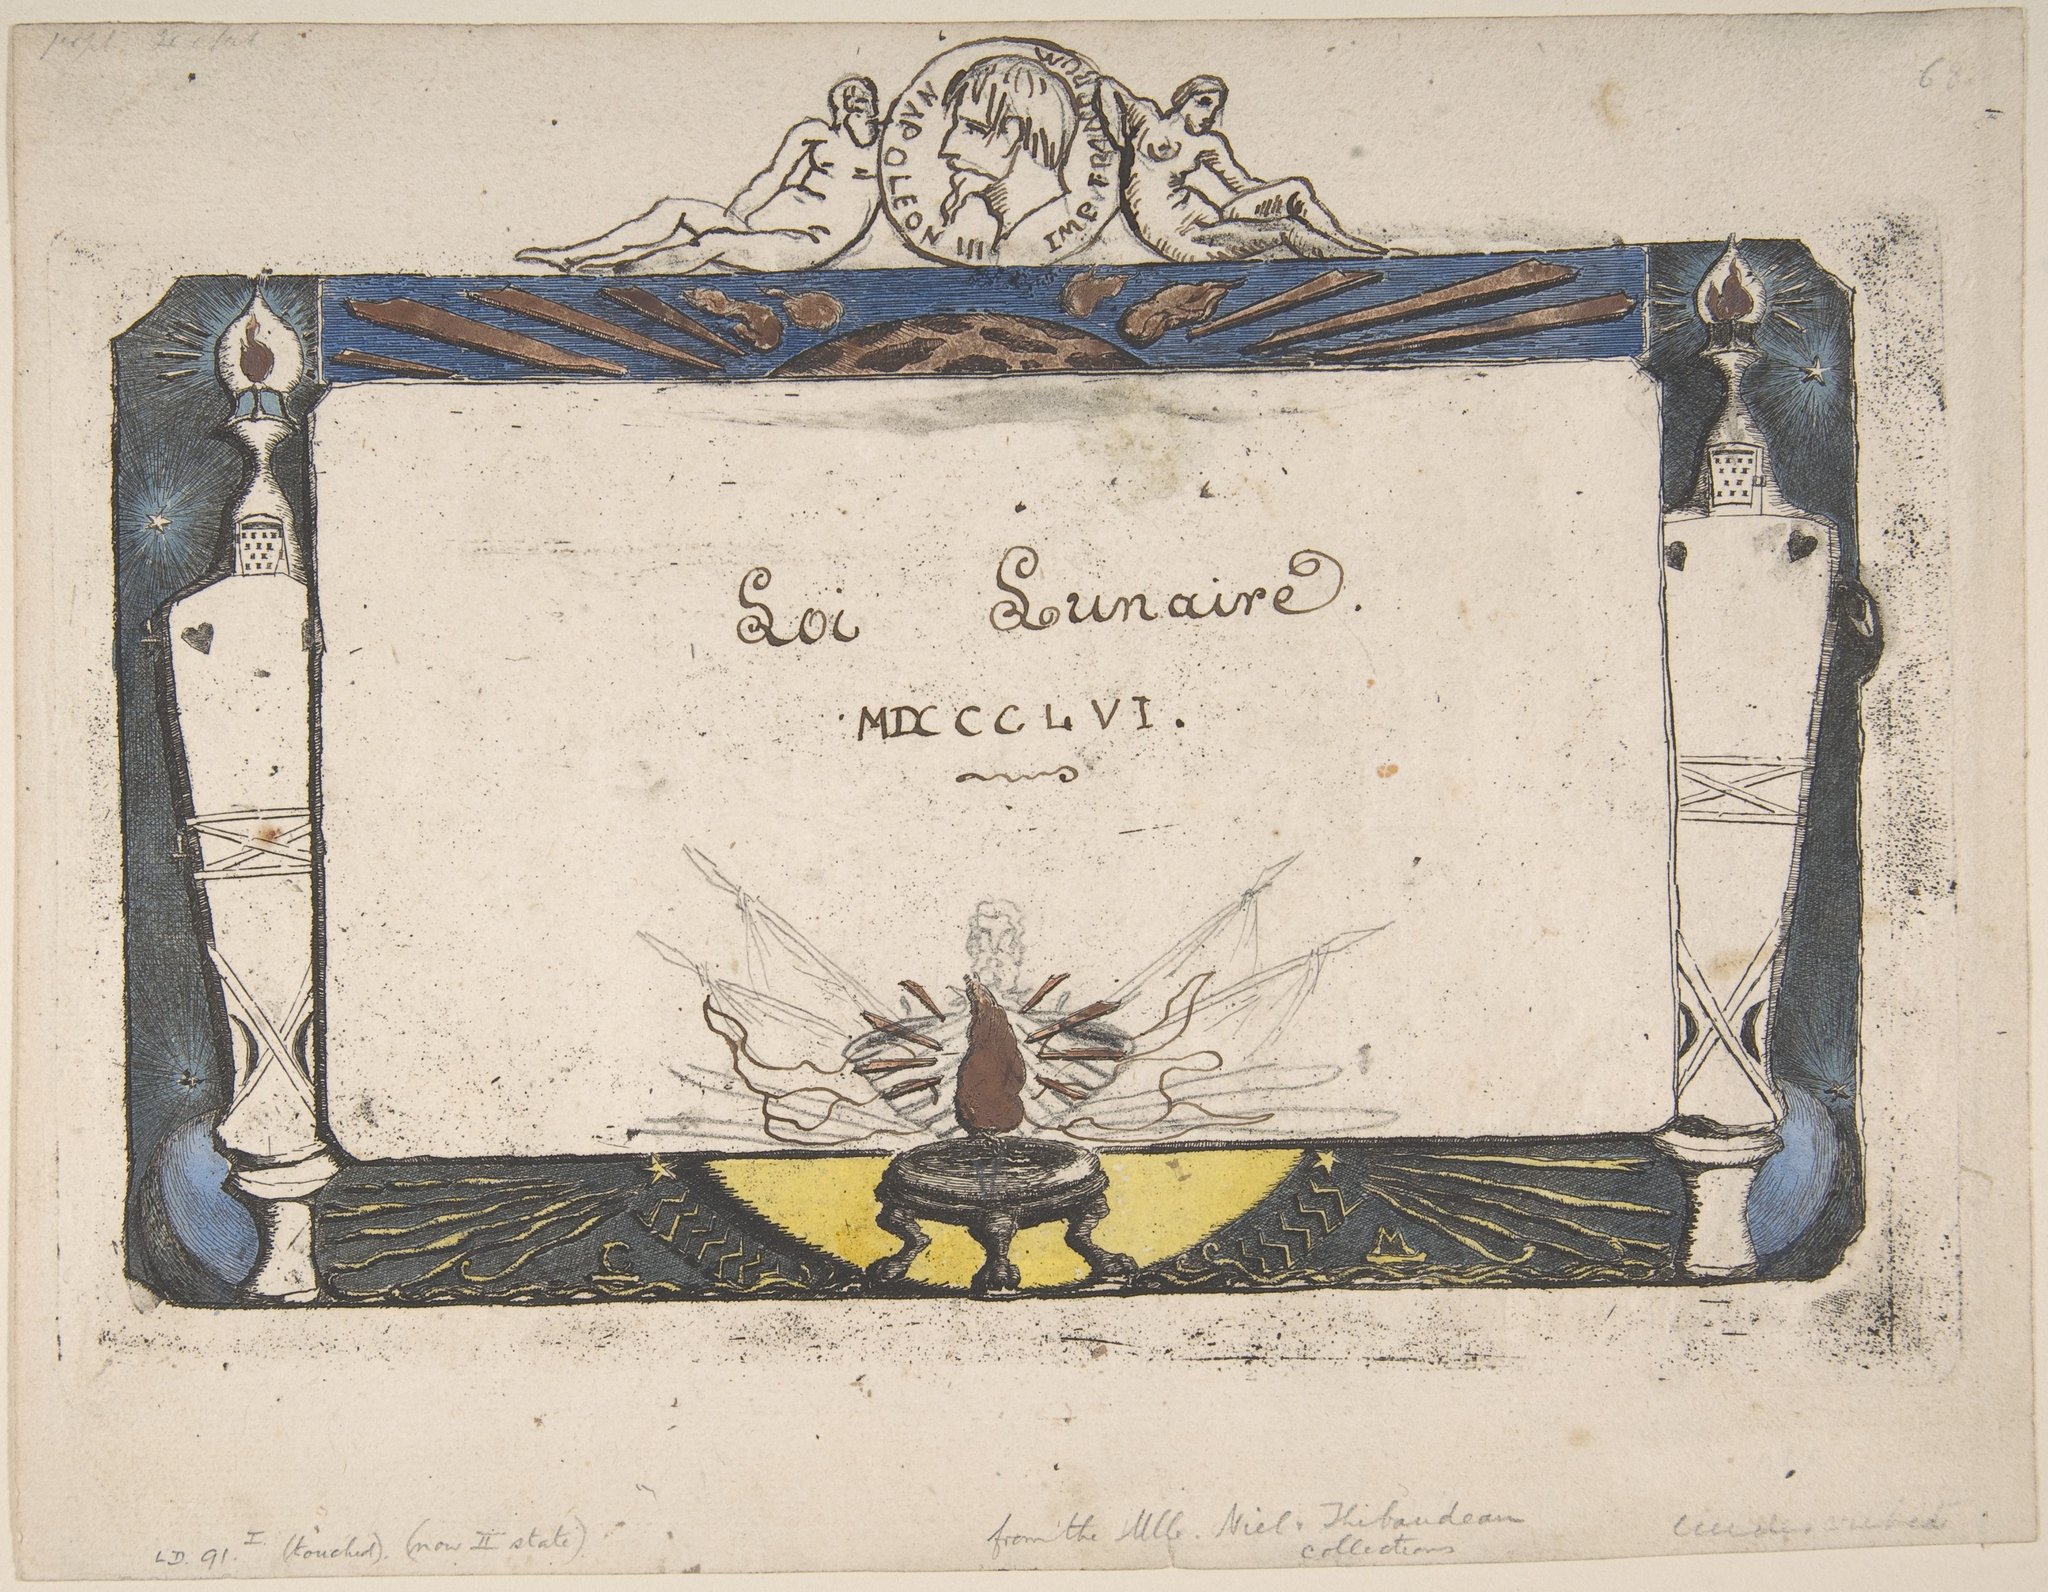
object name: drawing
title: Lunar Law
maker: charles meryon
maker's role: artist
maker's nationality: french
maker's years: 1821-1868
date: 1856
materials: graphite, ink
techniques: brush, etching, pen, wash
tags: male nudes,profiles,female nudes